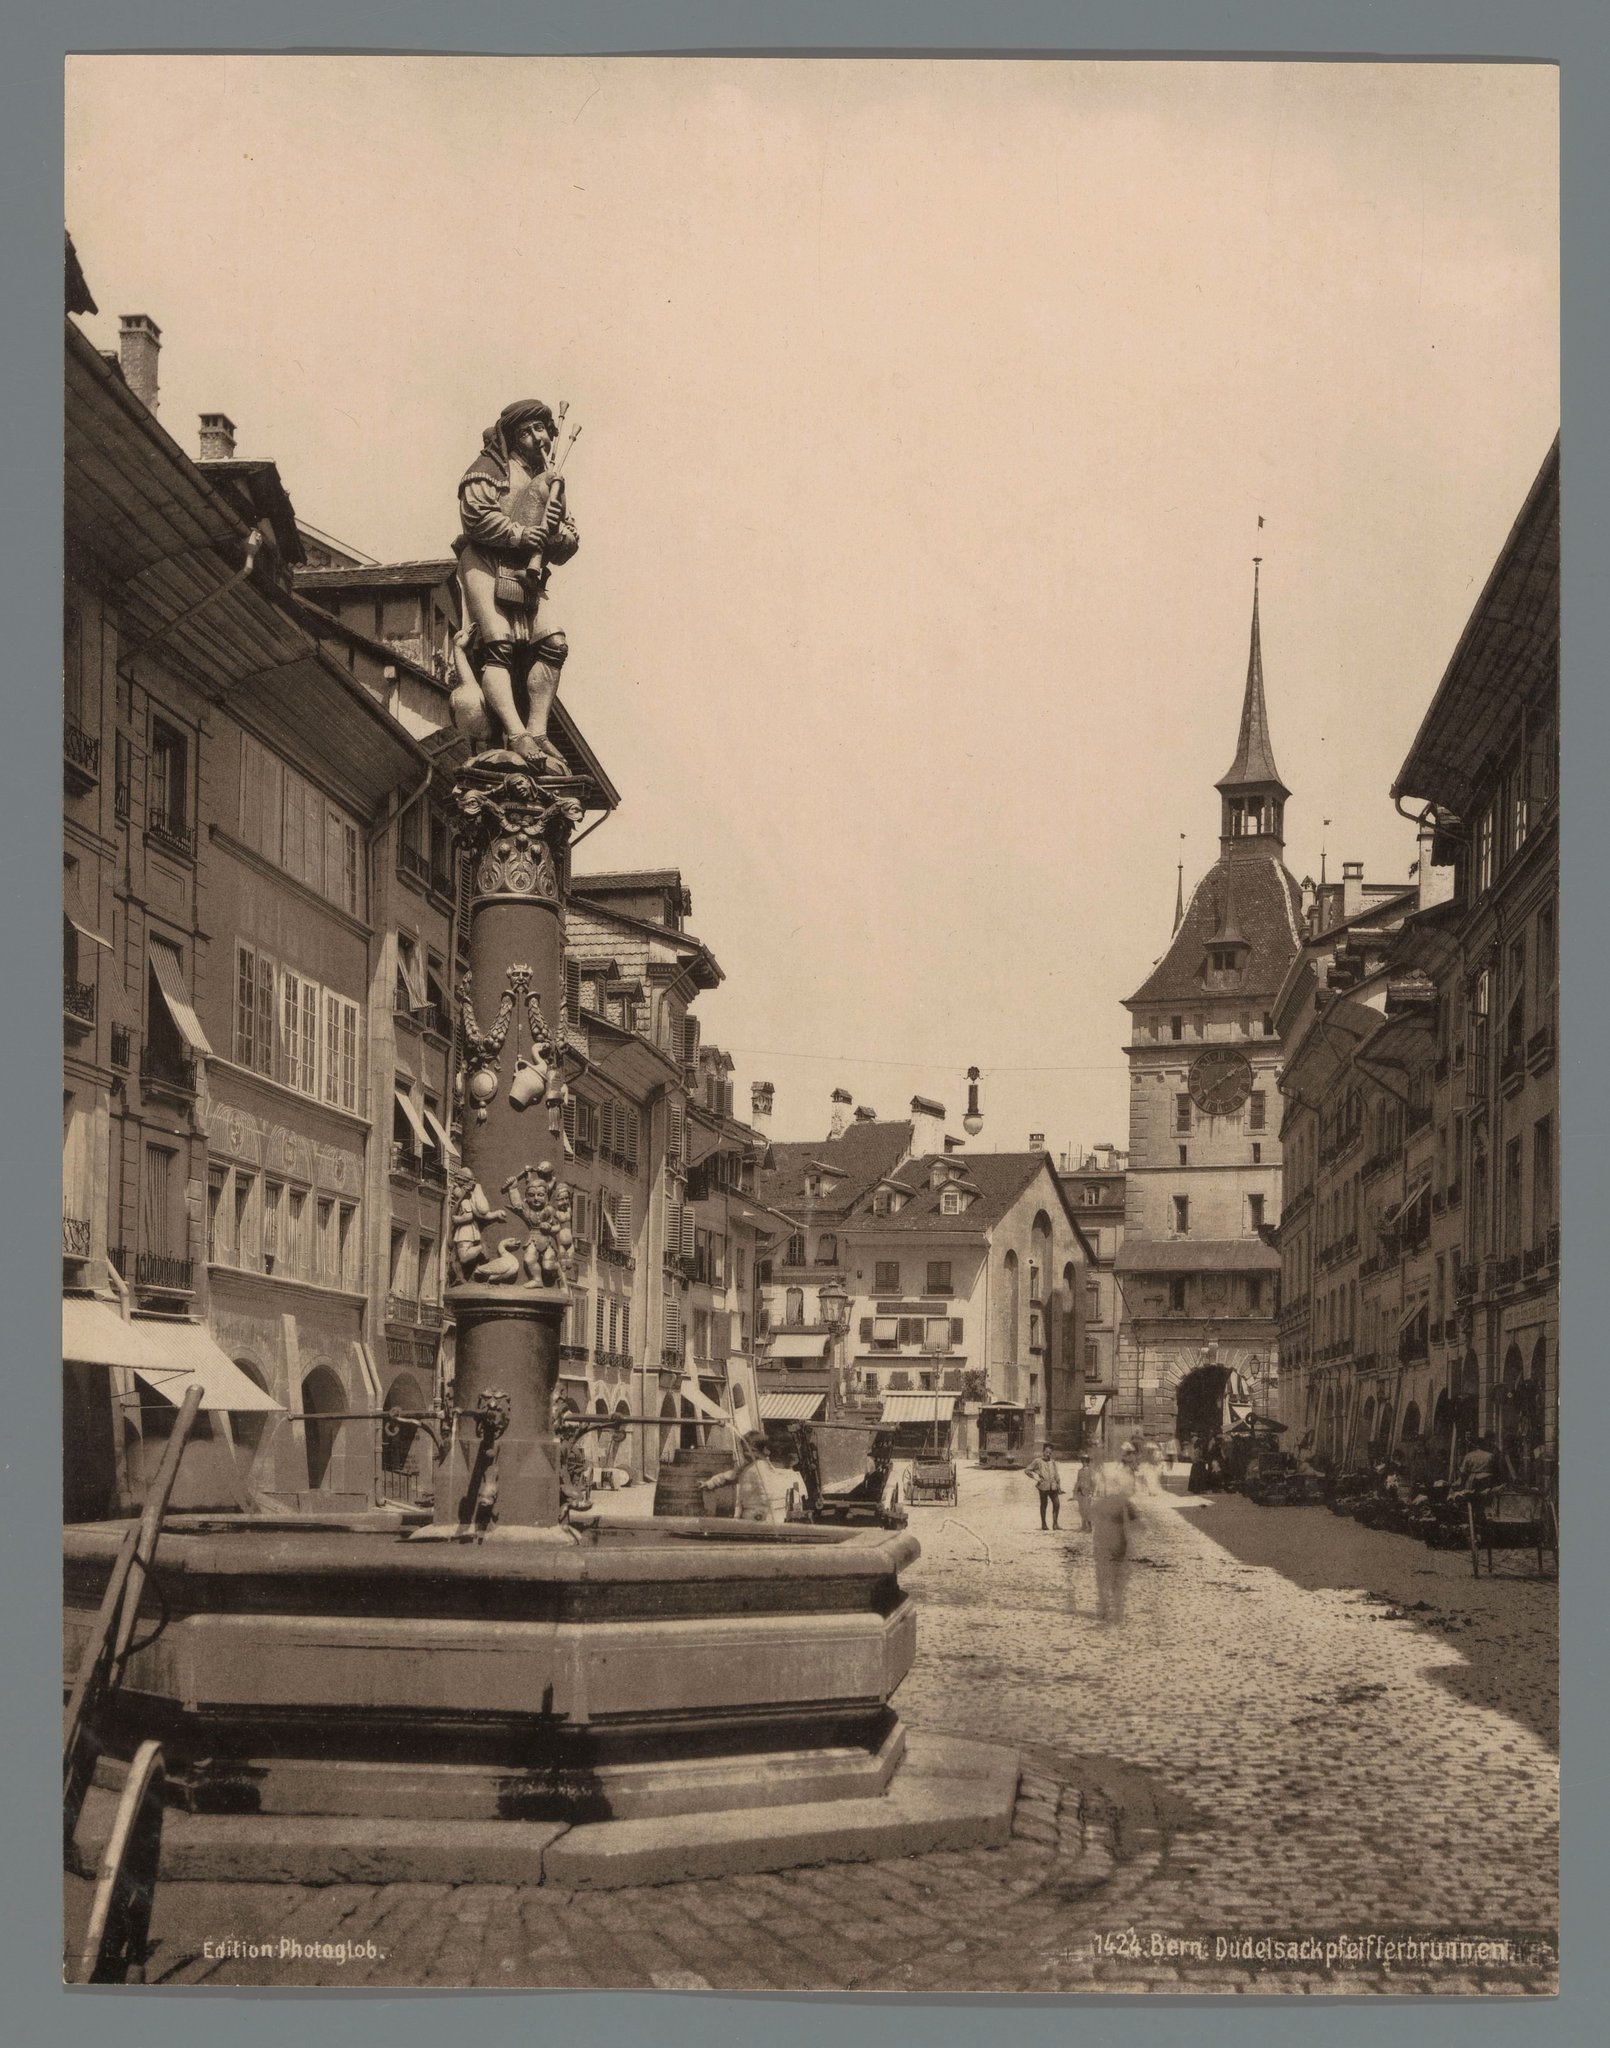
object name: photomechanical print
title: Bern, Dudelsackpfeifferbrunnen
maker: Anonymous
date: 1919-1930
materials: paper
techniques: photograph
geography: zurich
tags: ornamental fountain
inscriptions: number: ‘1424.’